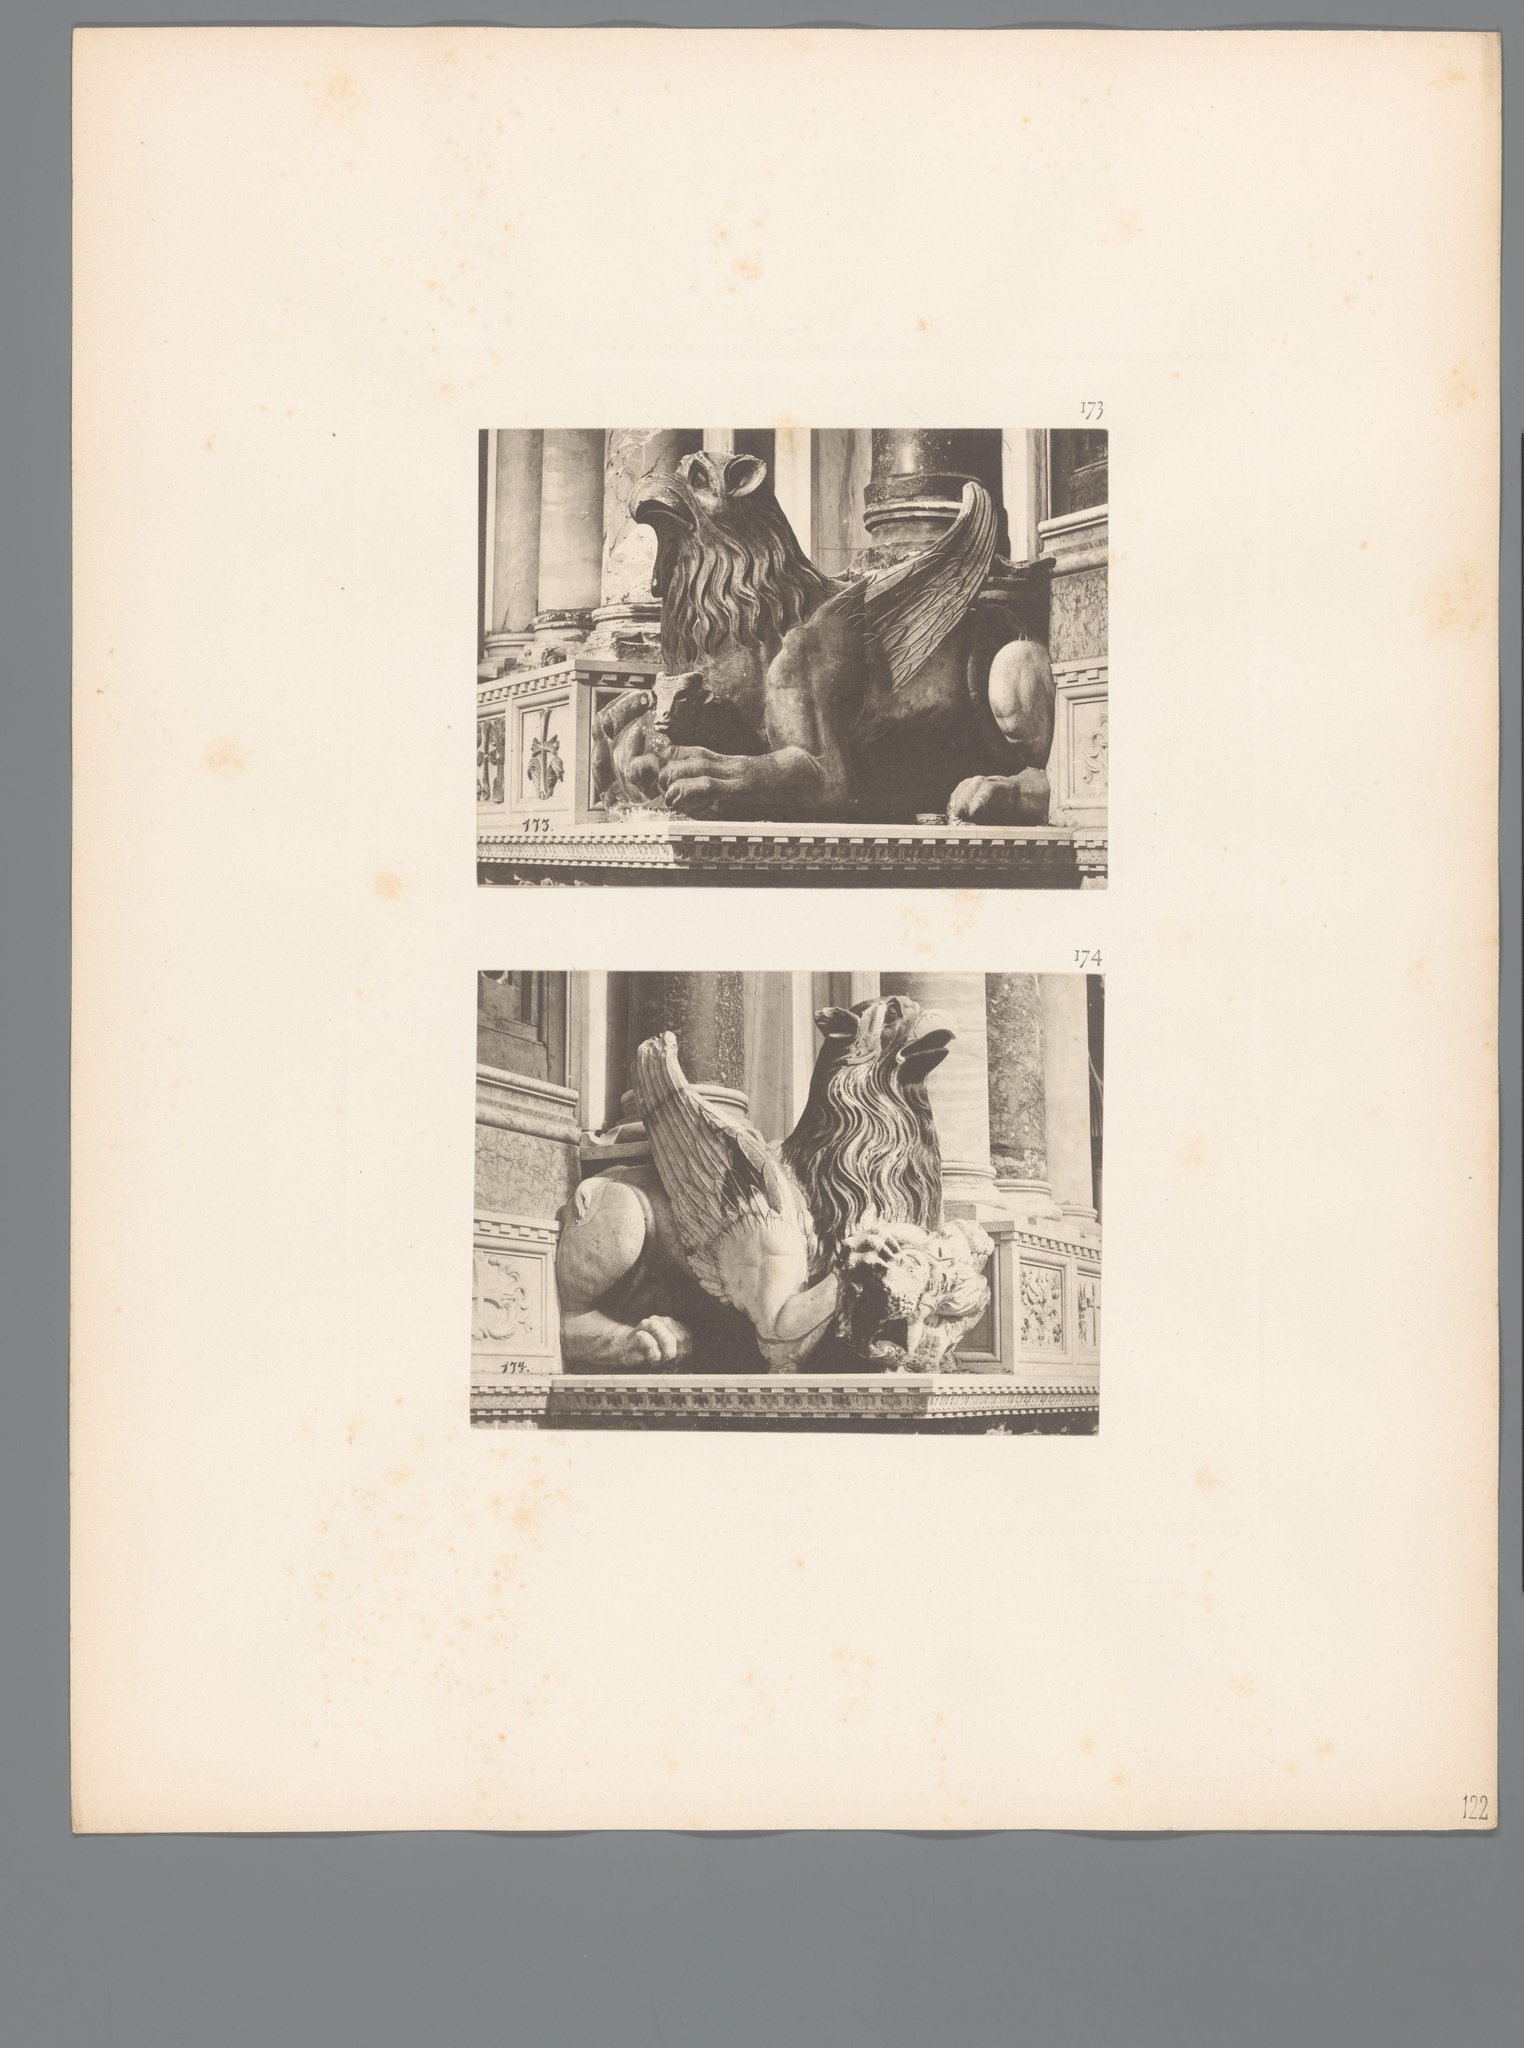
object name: photomechanical print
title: Twee afbeeldingen van griffioenen van de San Marco in Venetië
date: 1879-1884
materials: paper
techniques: photograph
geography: venice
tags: griffin (lion/eagle); 'griffo' (ripa), church (exterior)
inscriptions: number: ‘174.’, number: ‘173’, number: ‘174’, number: ‘173.’, number: ‘122’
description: Deze prenten maken deel uit van een omslag met 51 prenten op 29 bladen en 1 tekstblad.